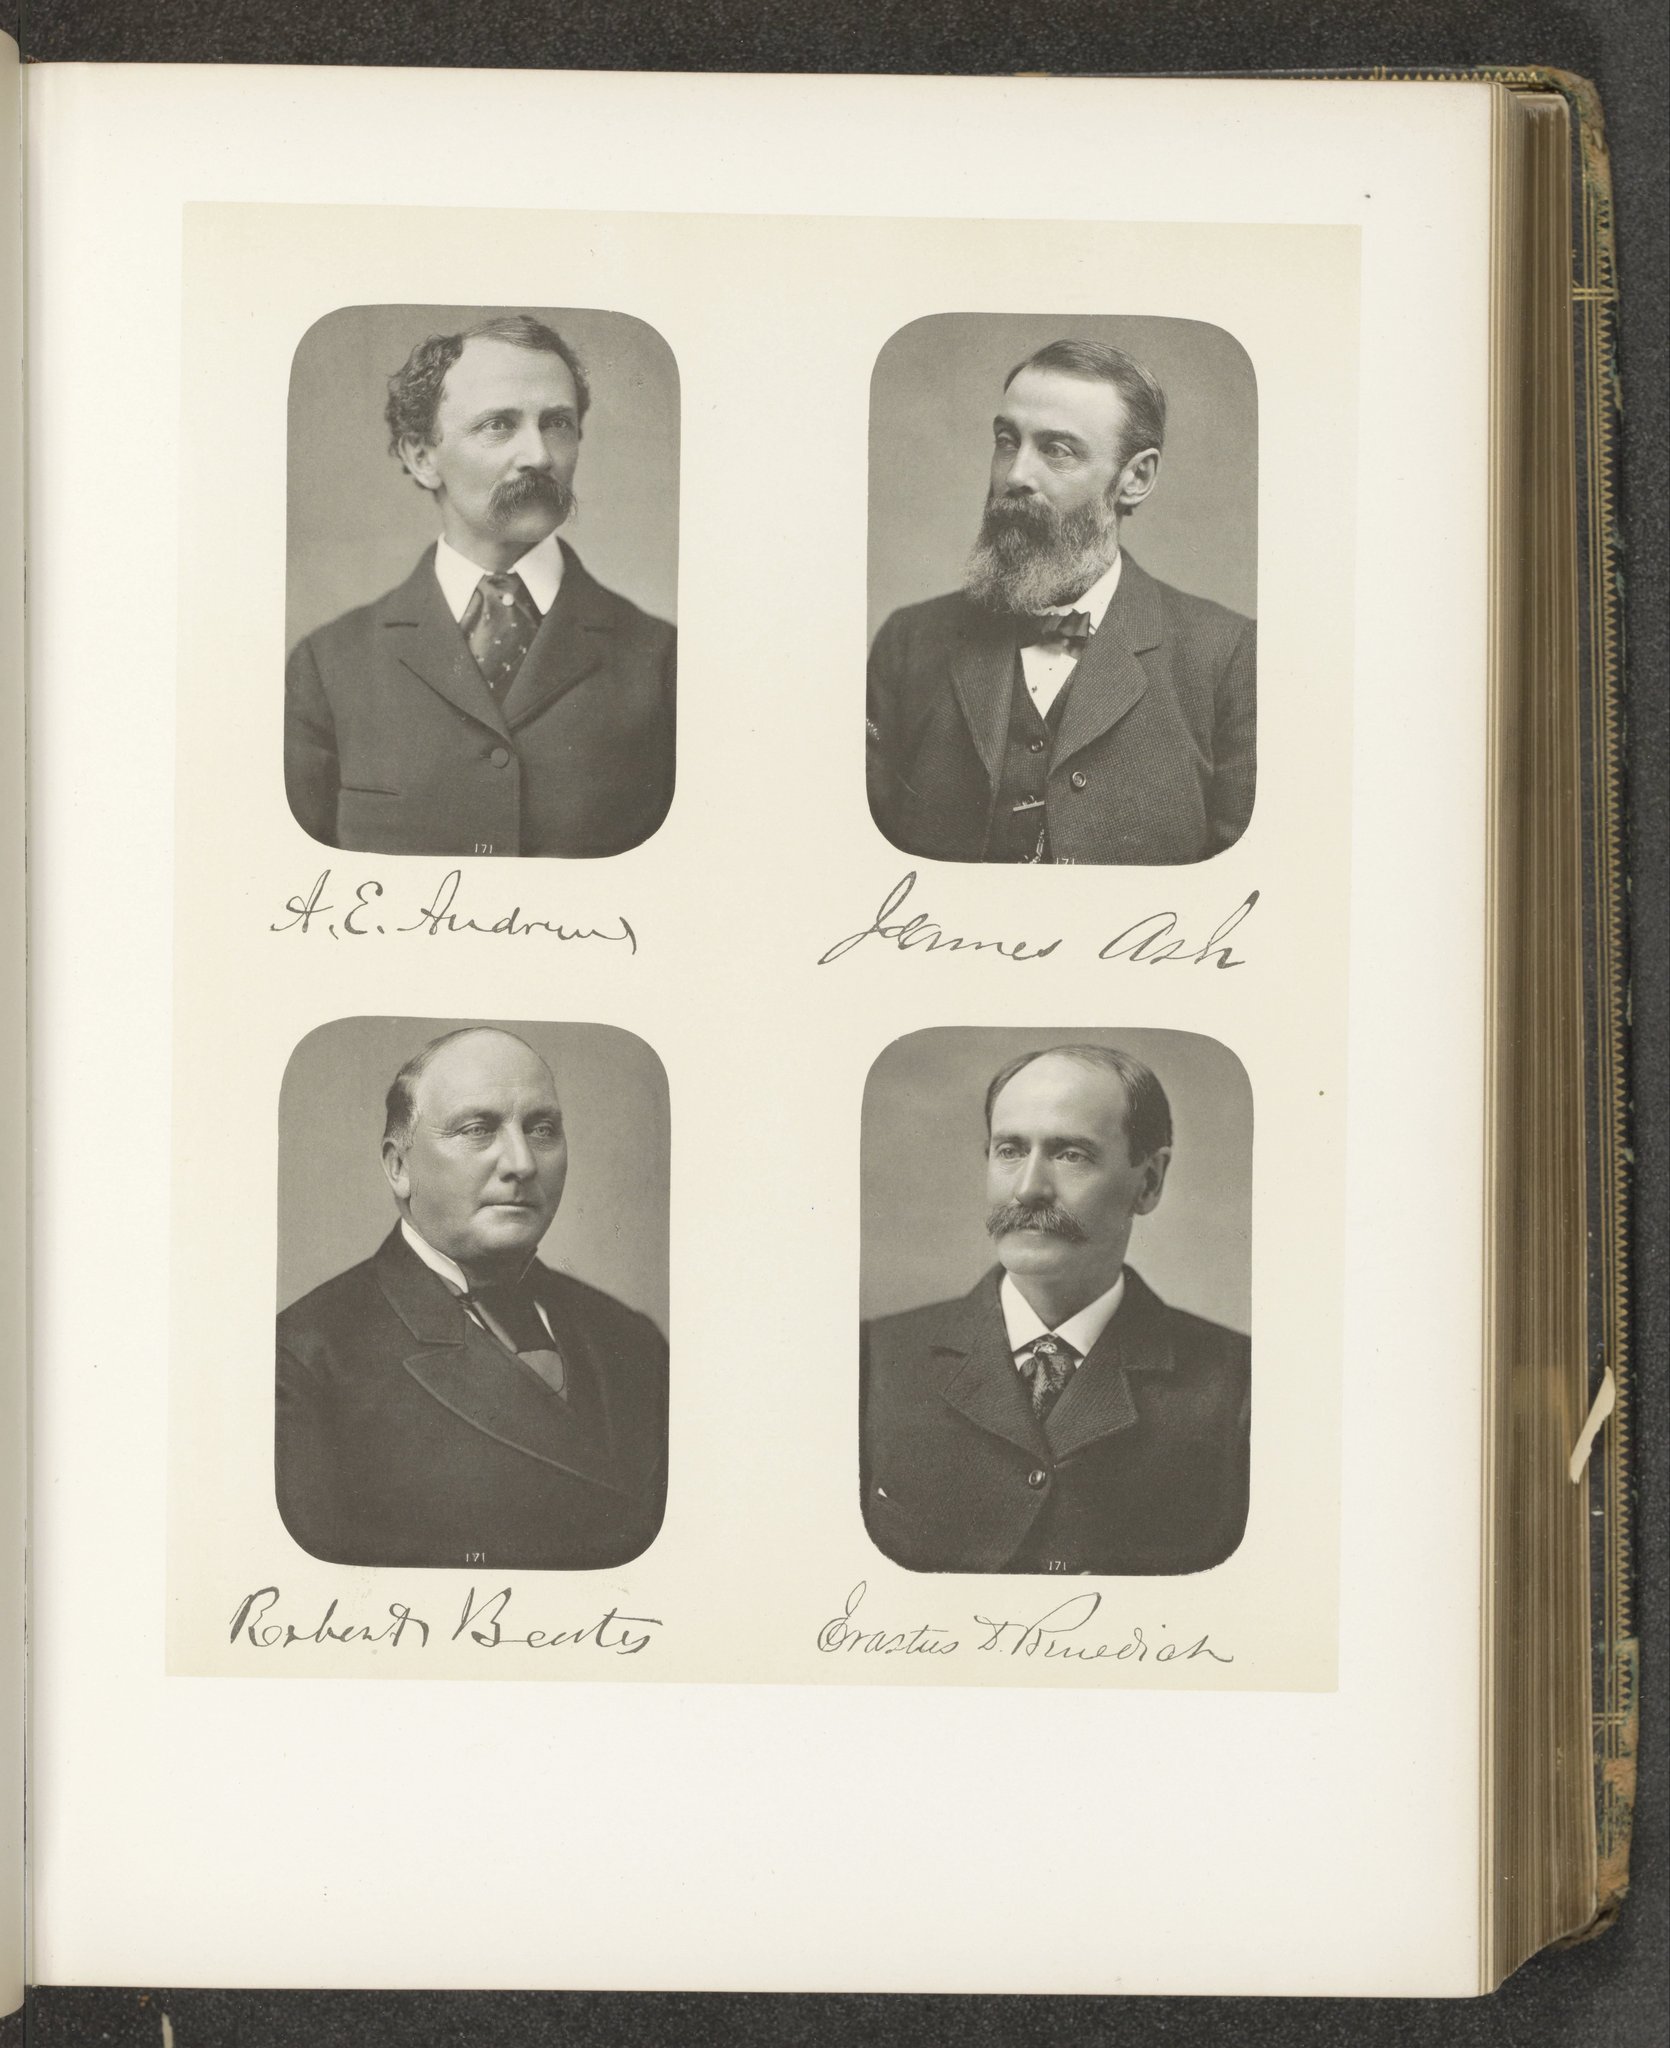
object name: page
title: Portretten van vier leden van het Lagerhuis van de staat New York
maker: Anonymous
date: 1872-1882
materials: paper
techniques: photograph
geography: united states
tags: historical persons (portraits and scenes from the life) (+ head (and shoulders) (portrait))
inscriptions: number: ‘171’, annotation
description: Linksboven Alexander E. Andrews, rechtsboven James Ash, linksonder Robert Beates, rechtsonder Erastus D. Benedict.